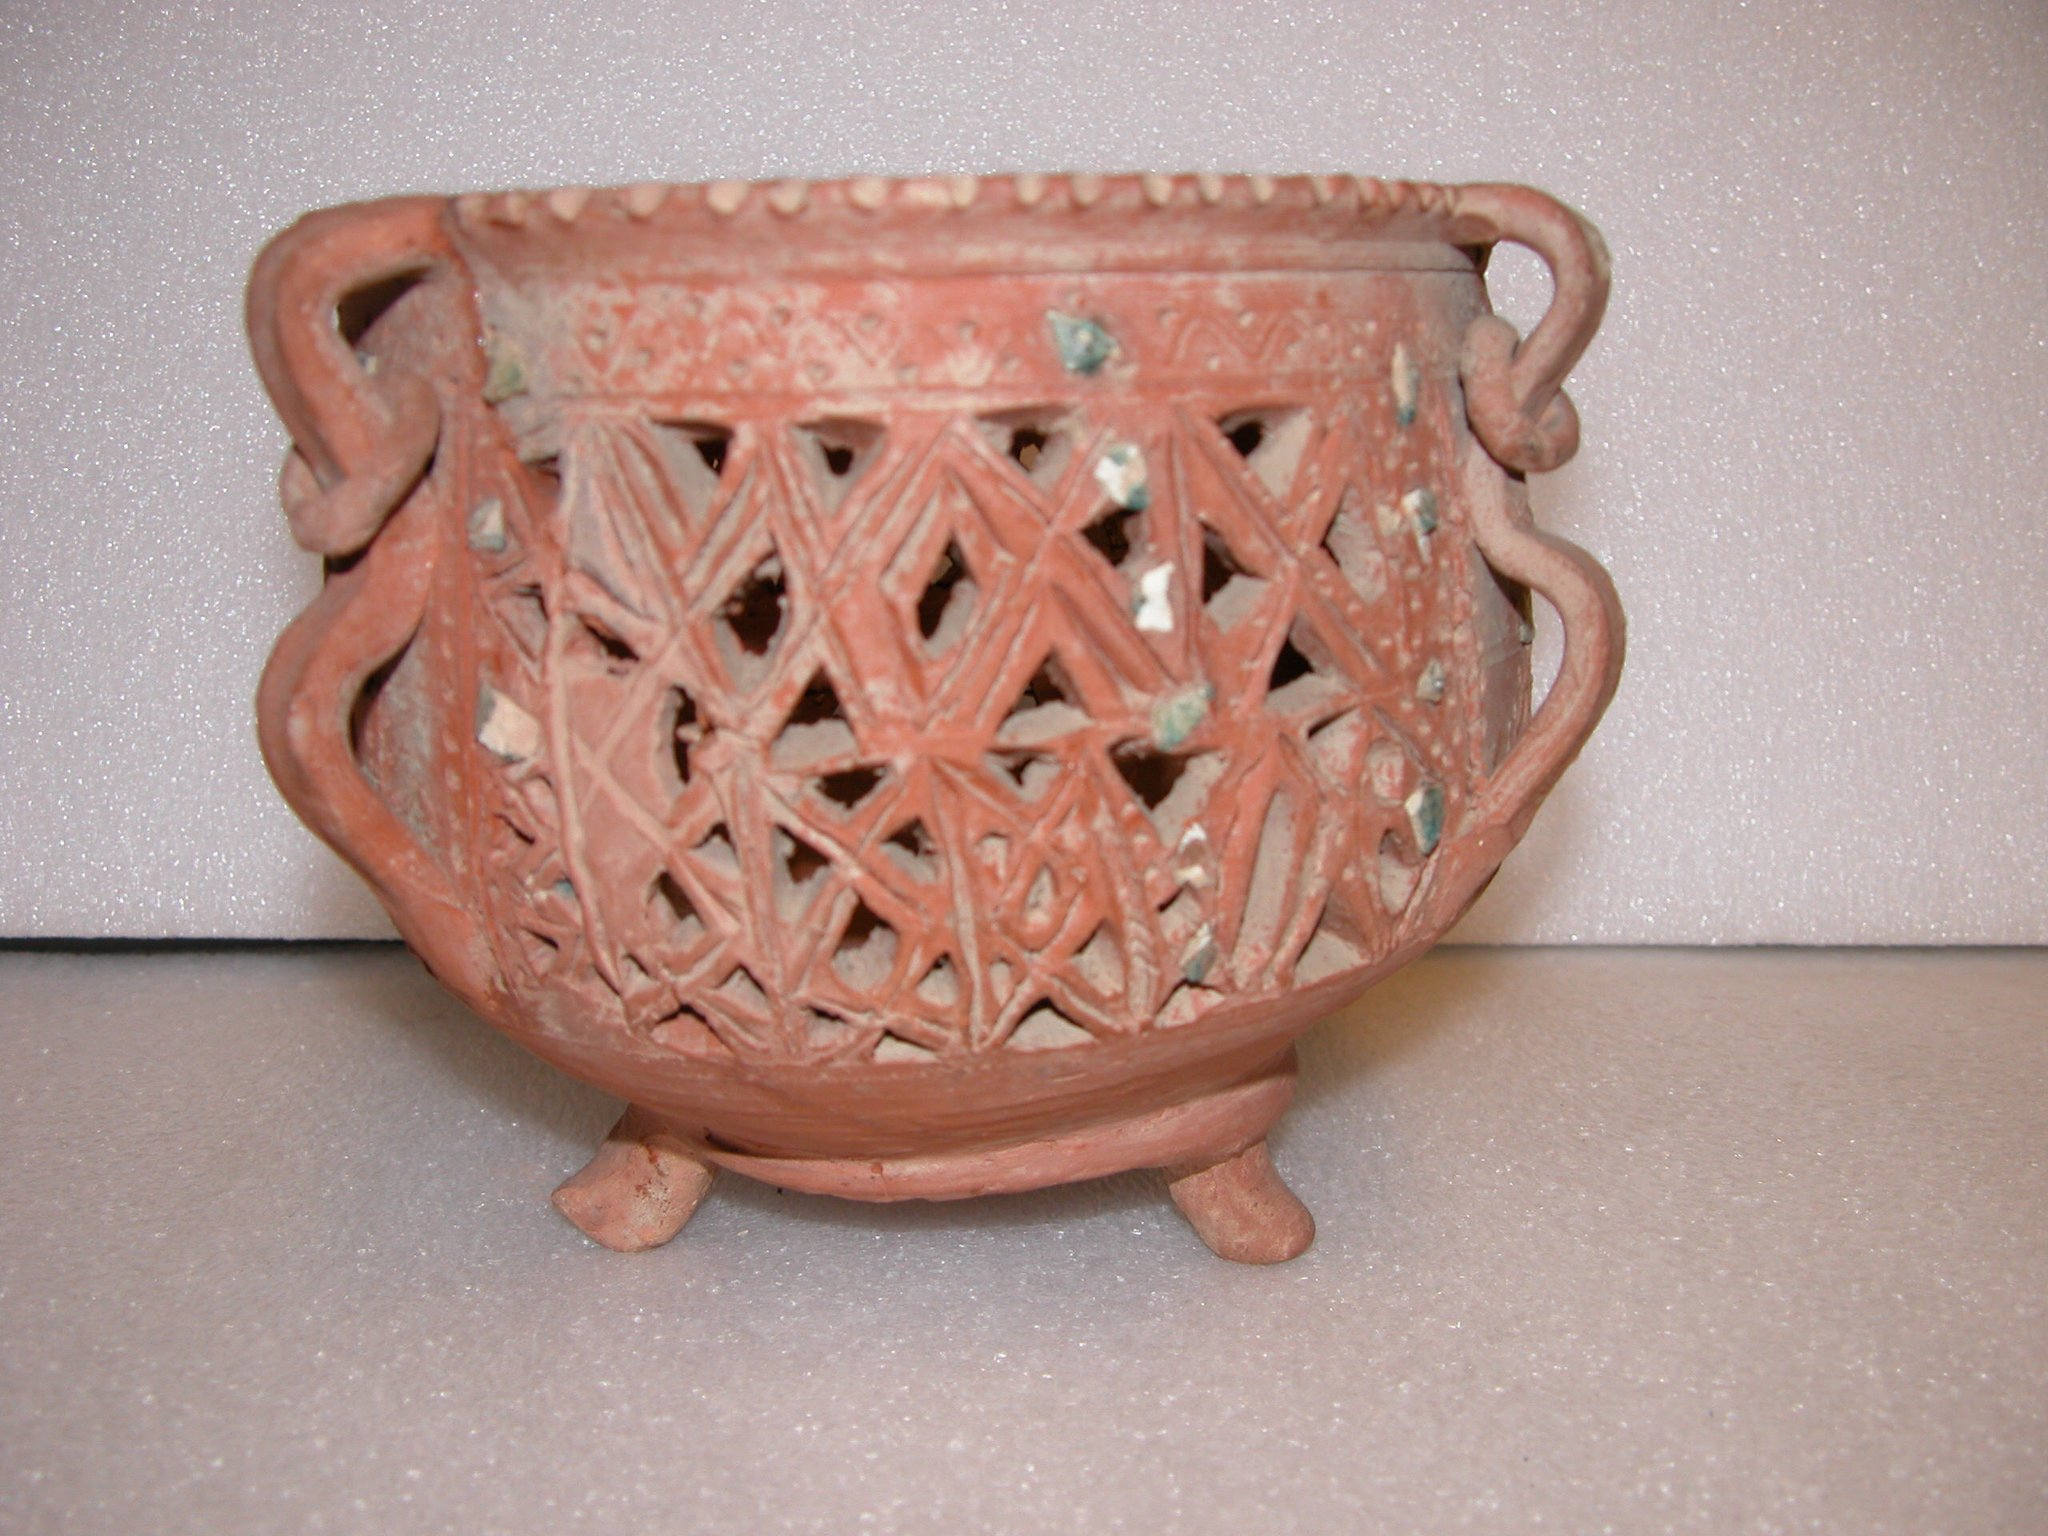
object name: vase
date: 1101-1200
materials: earthenware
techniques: cutting, incising, tooling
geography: iran